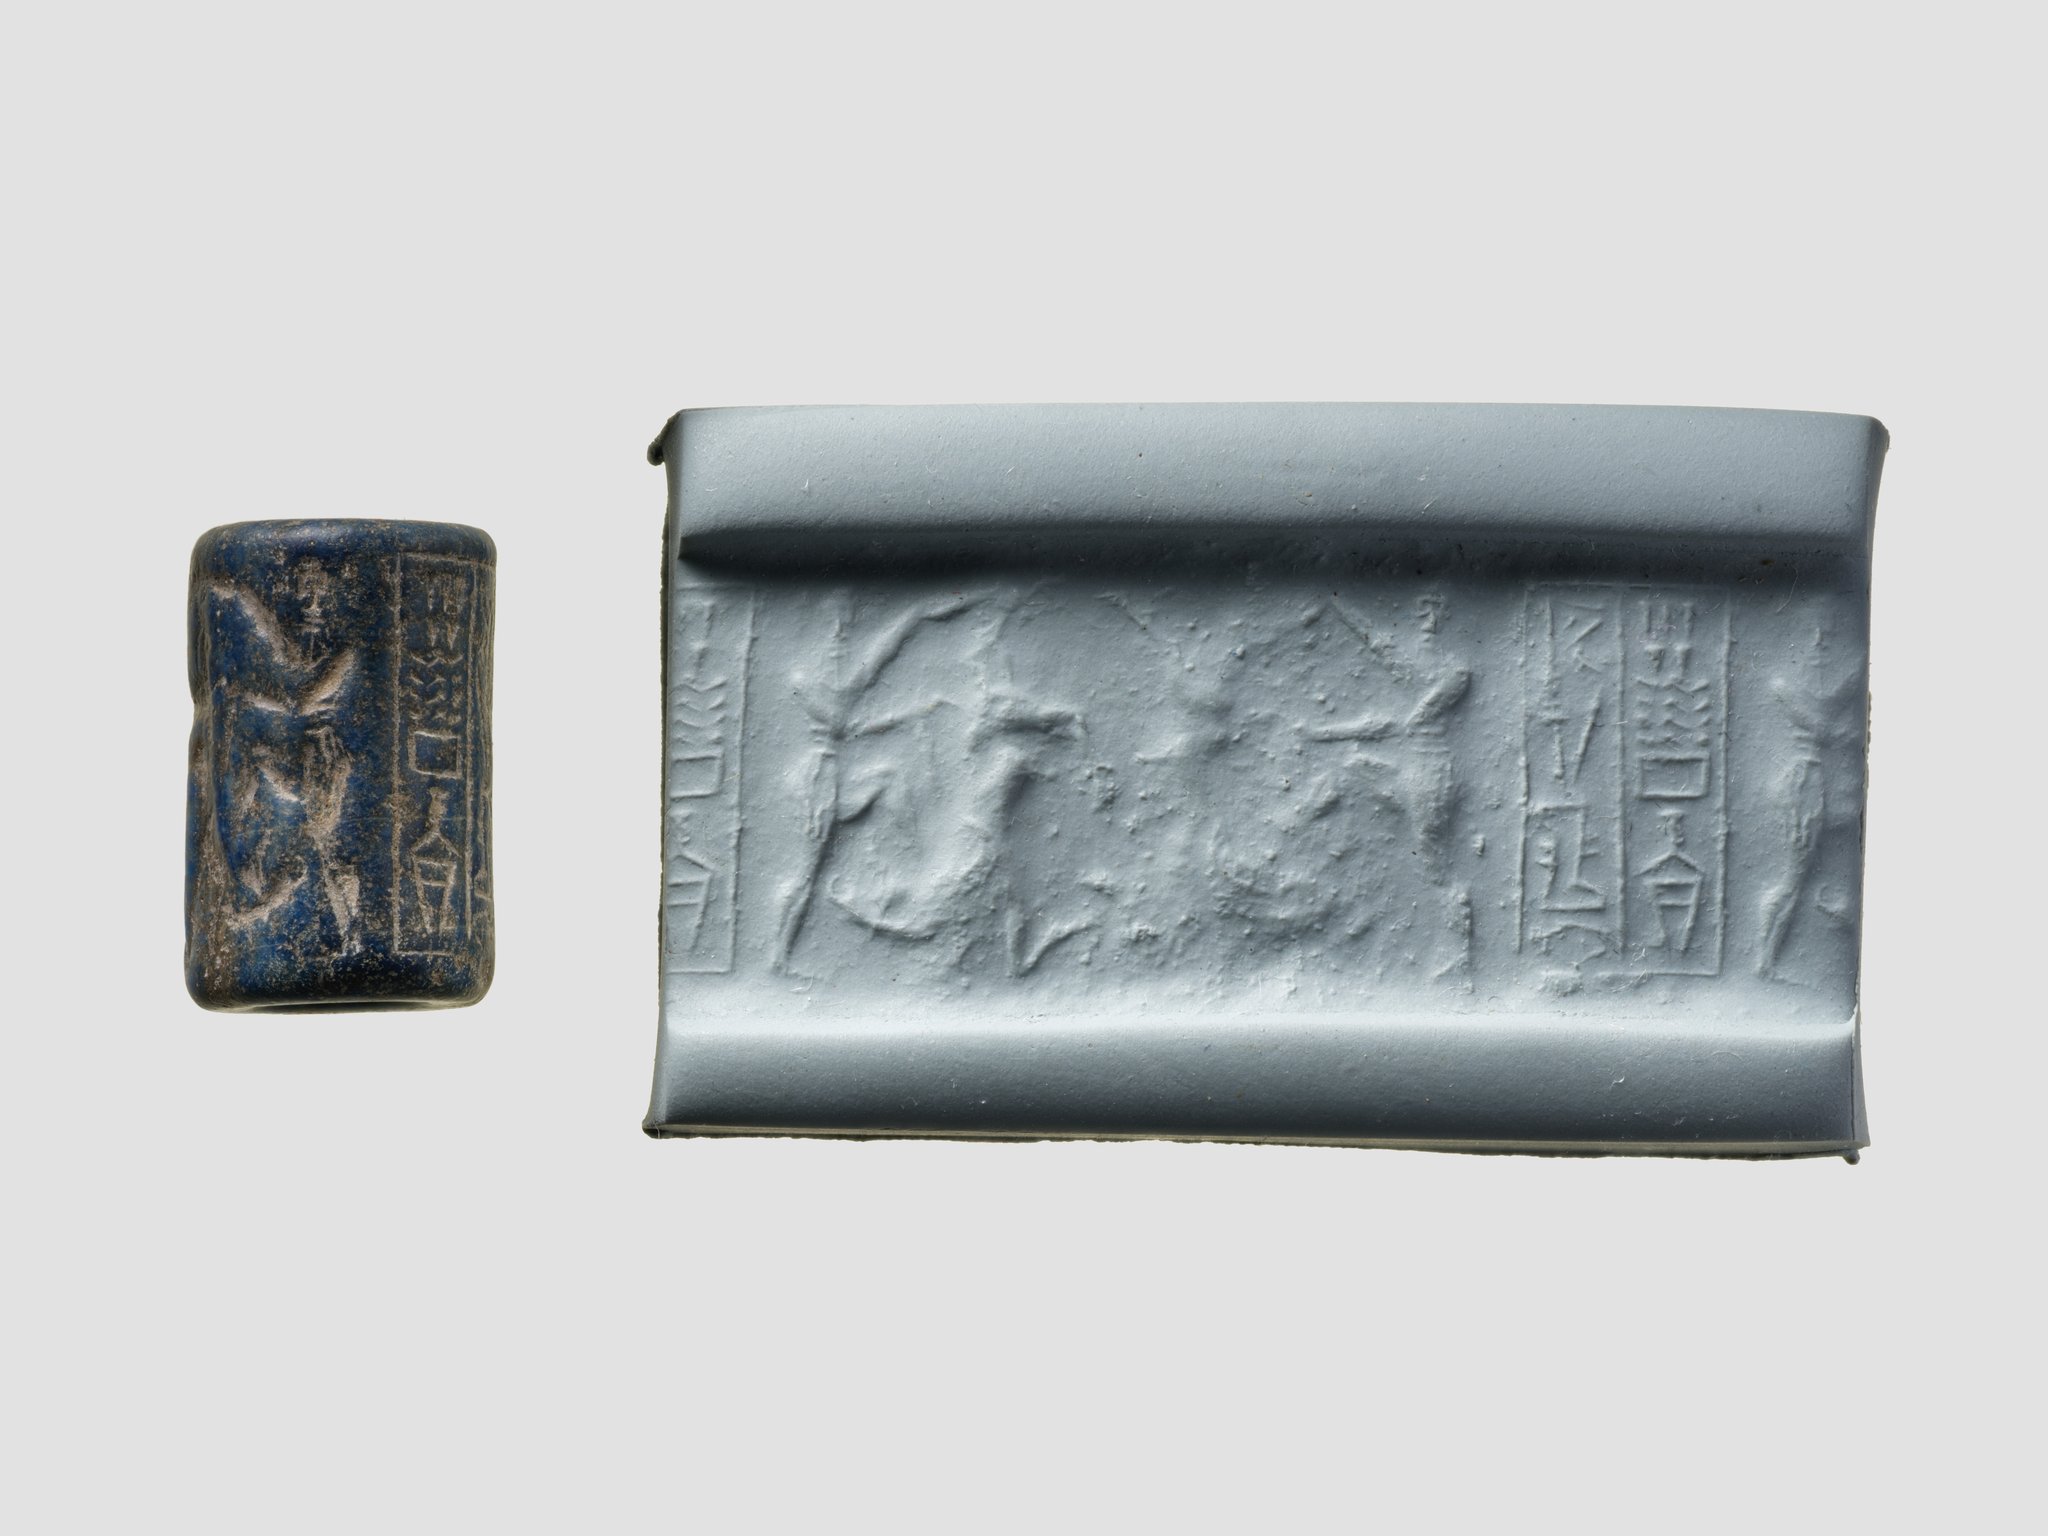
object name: cylinder seal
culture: akkadian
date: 2350-2150 BCE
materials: lapis lazuli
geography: mesopotamia